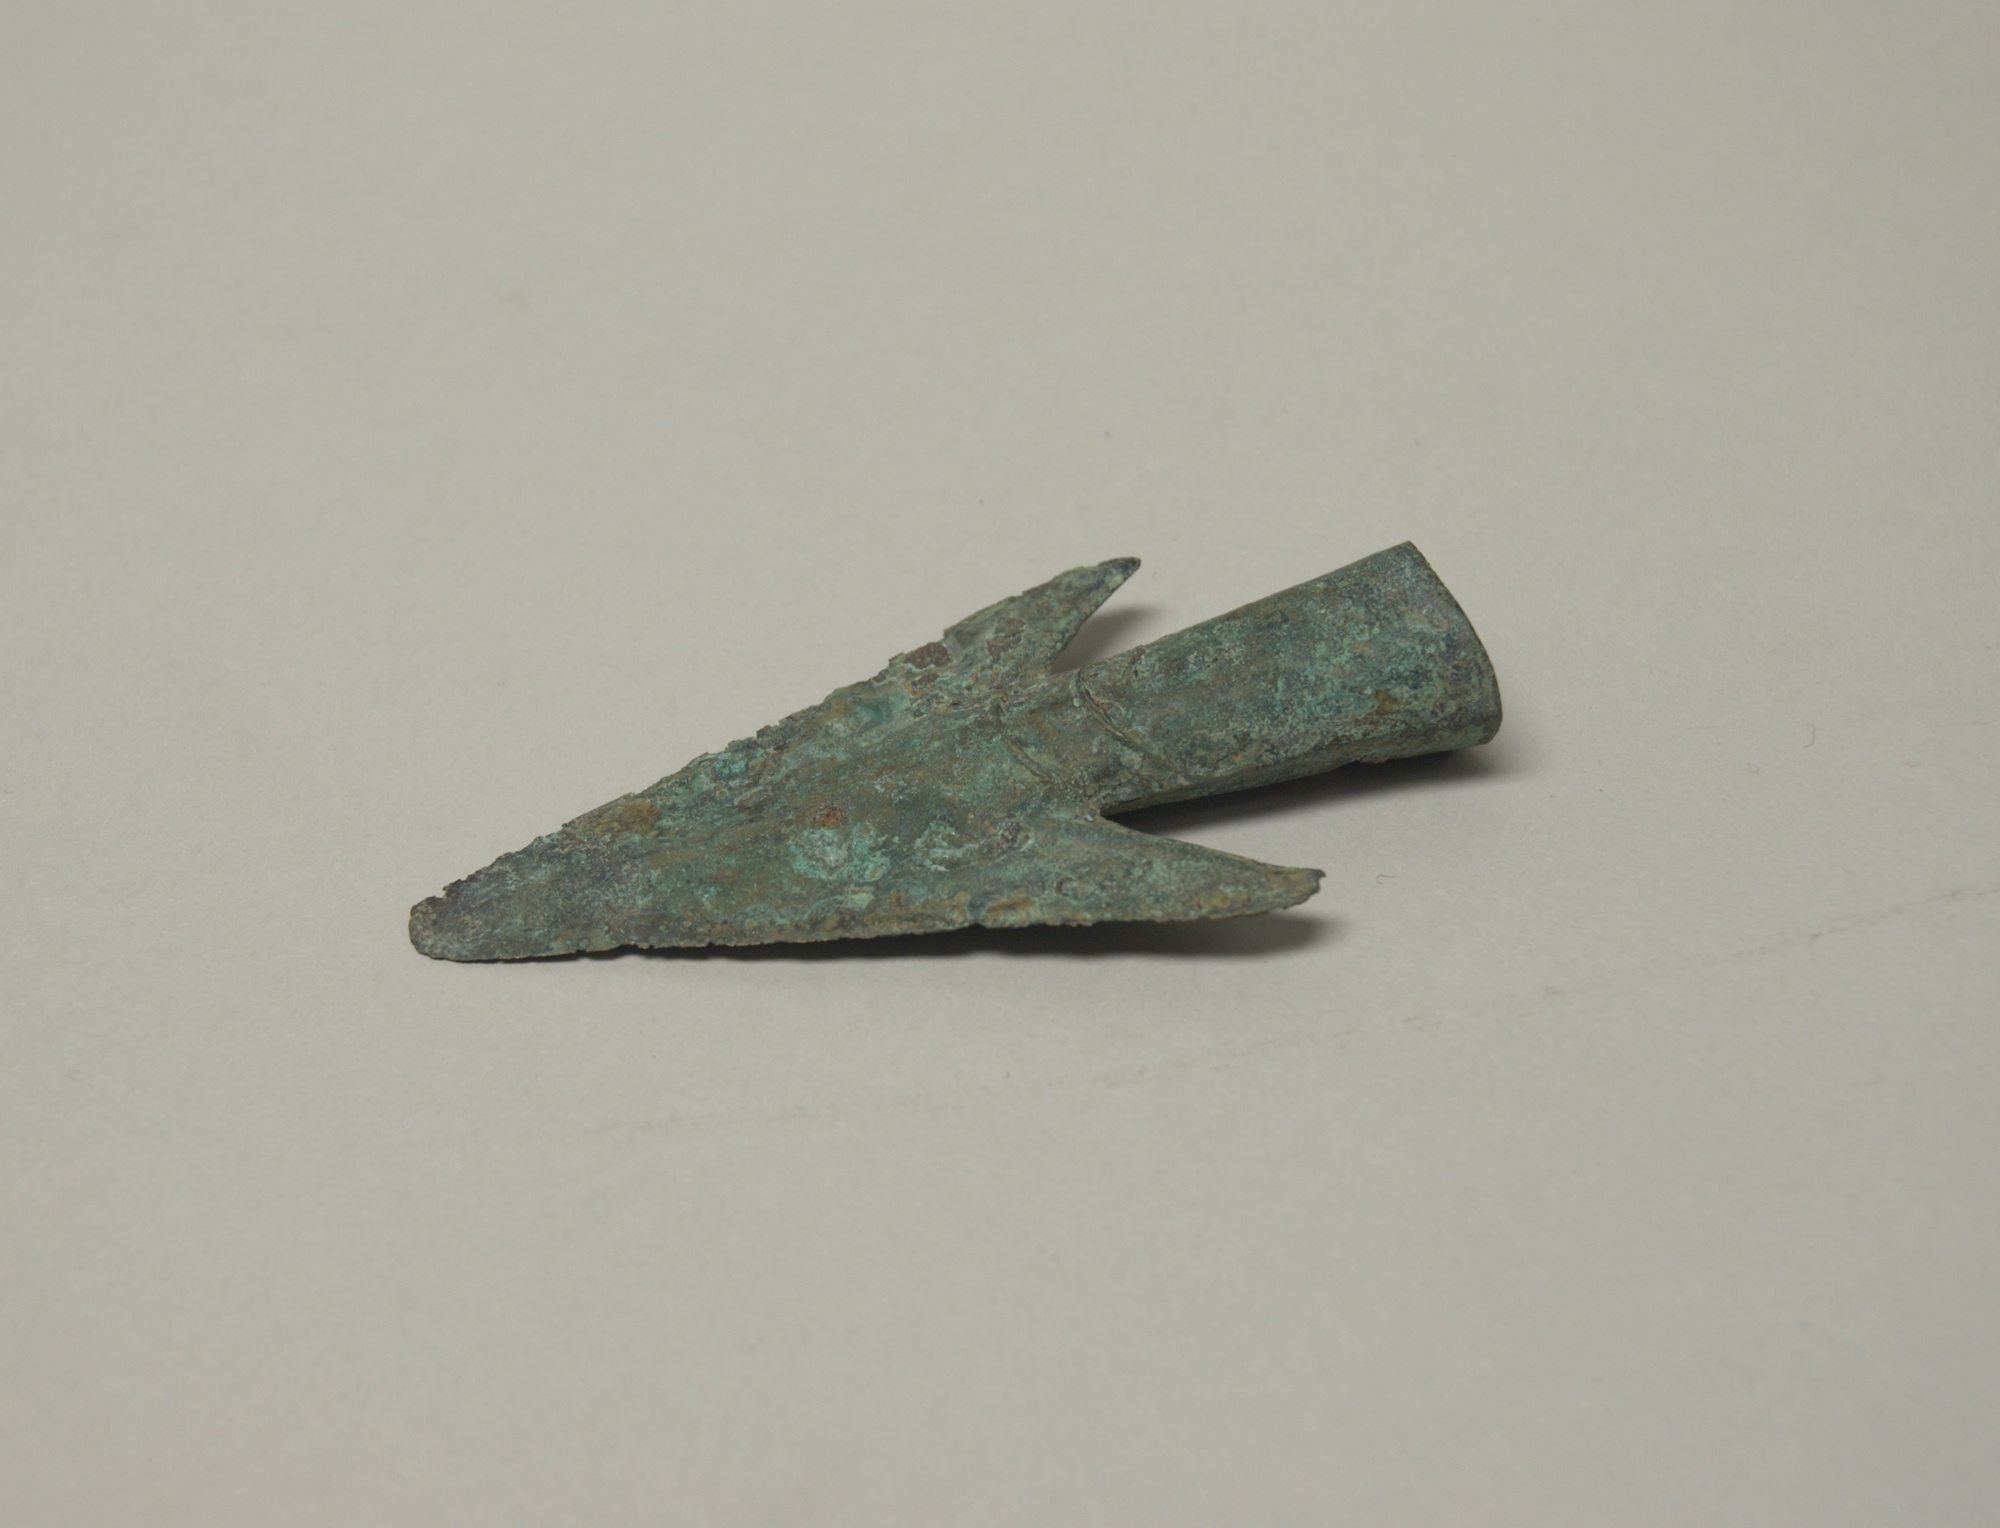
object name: spearhead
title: Arrow-Shaped Spearhead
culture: vietnamese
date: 500 BCE-300 CE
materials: bronze